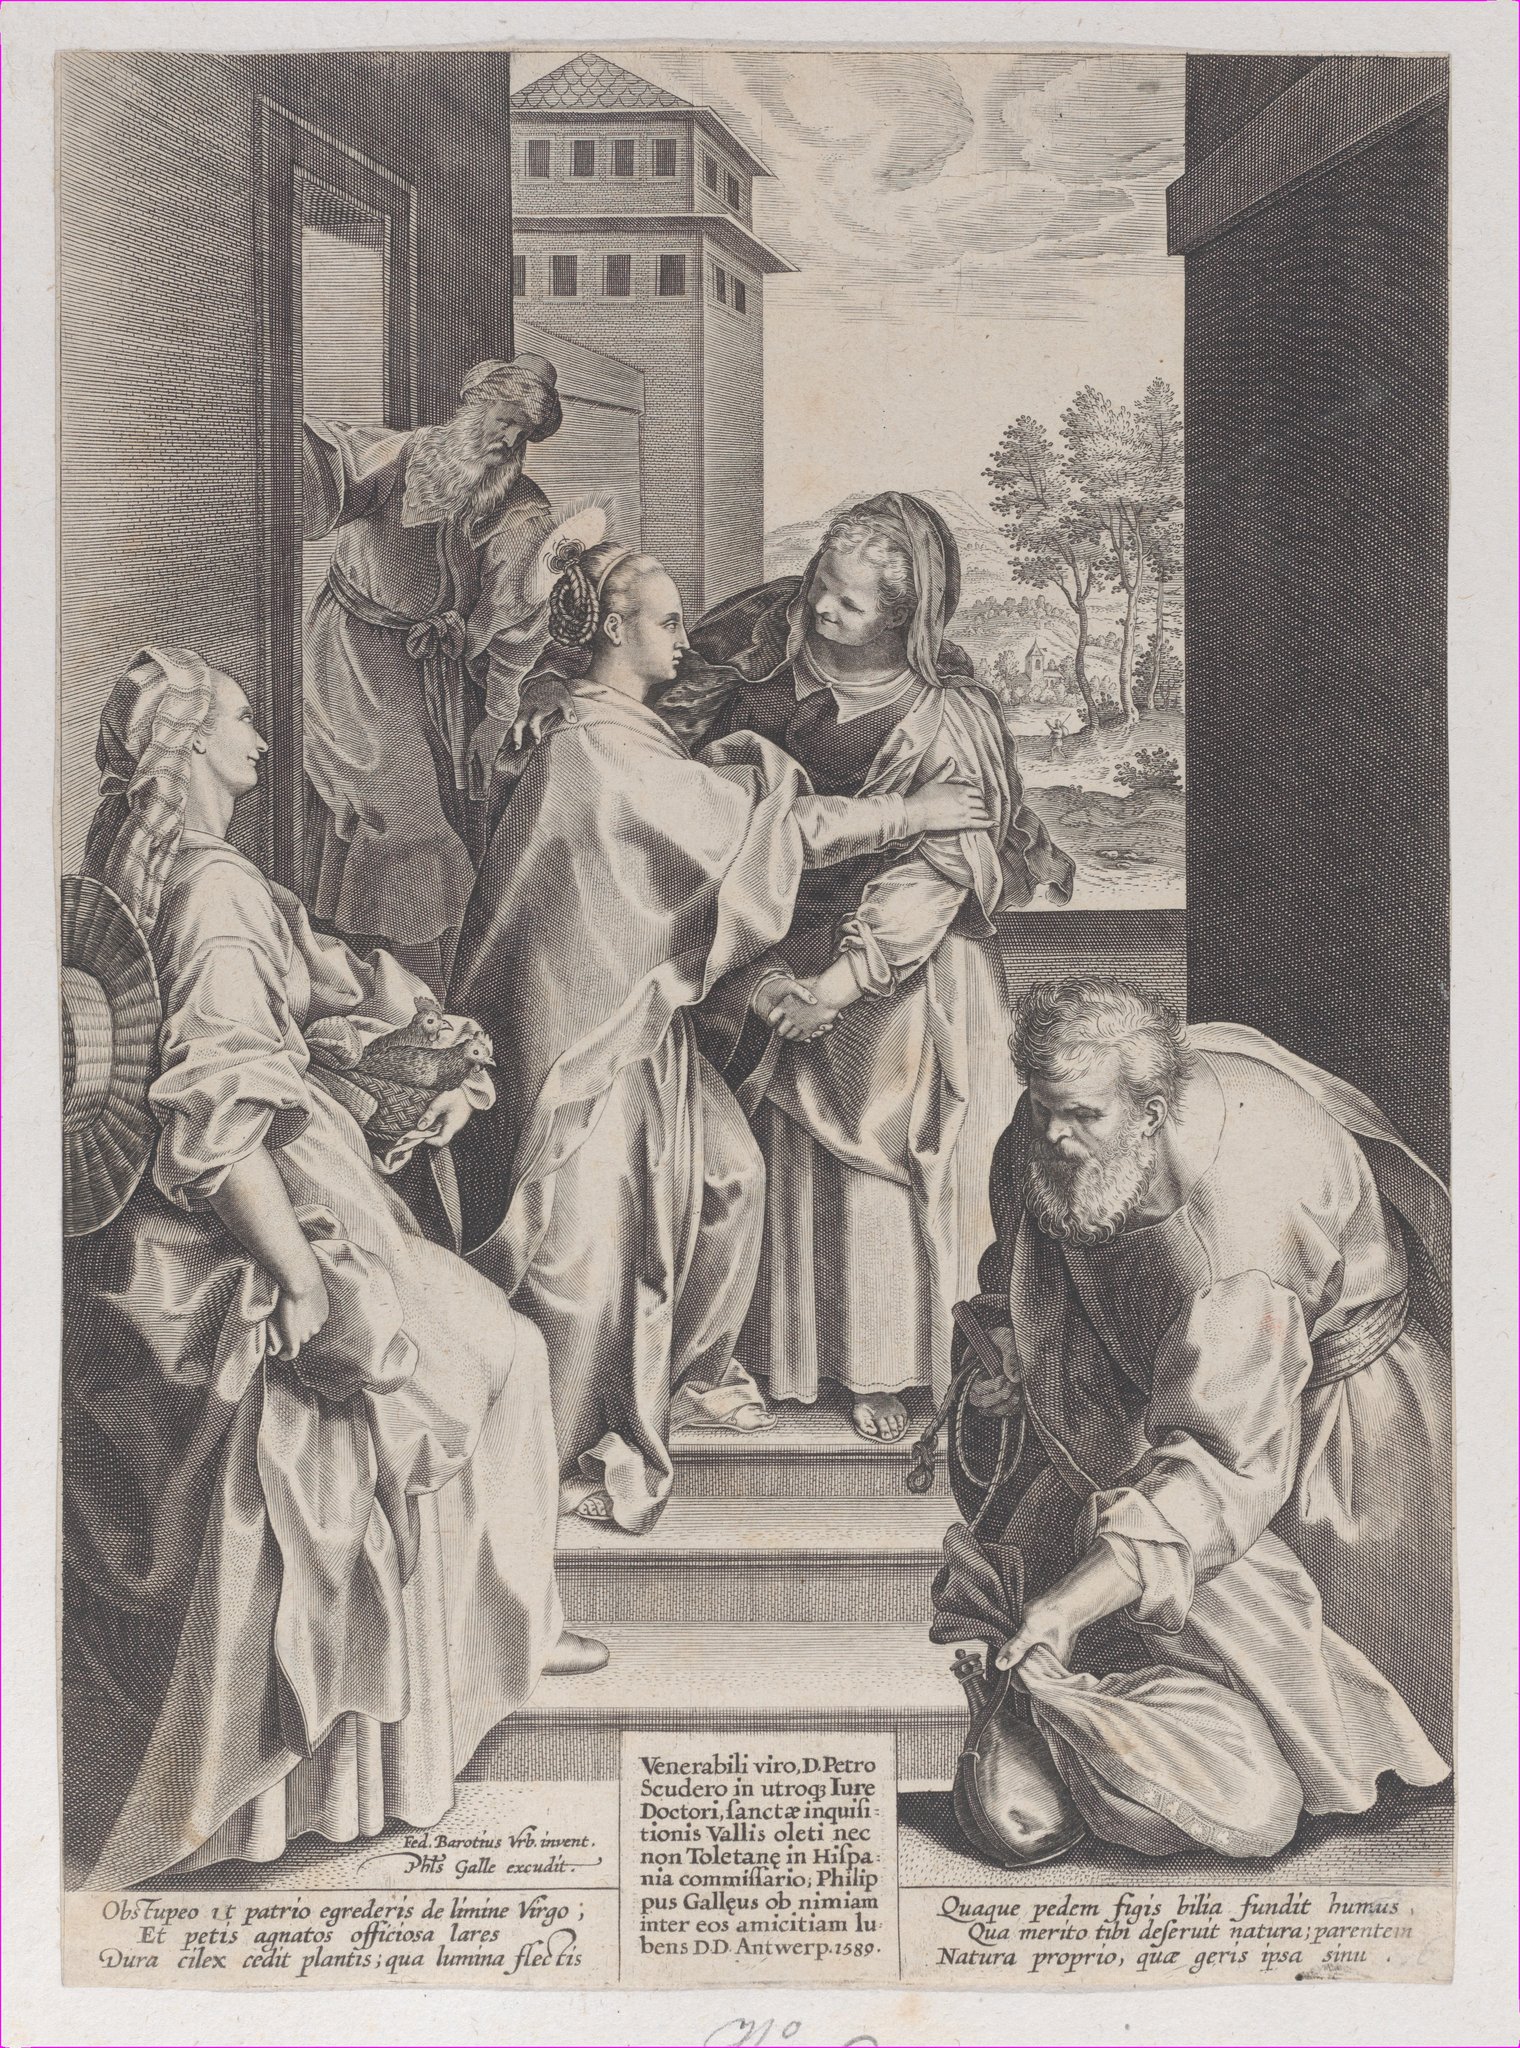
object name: print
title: The Visitation, the Virgin and Saint Elizabeth embracing in the center, flanked by other figures, after Barocci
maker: philips galle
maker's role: artist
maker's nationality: netherlandish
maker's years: 1537-1612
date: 1589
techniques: engraving